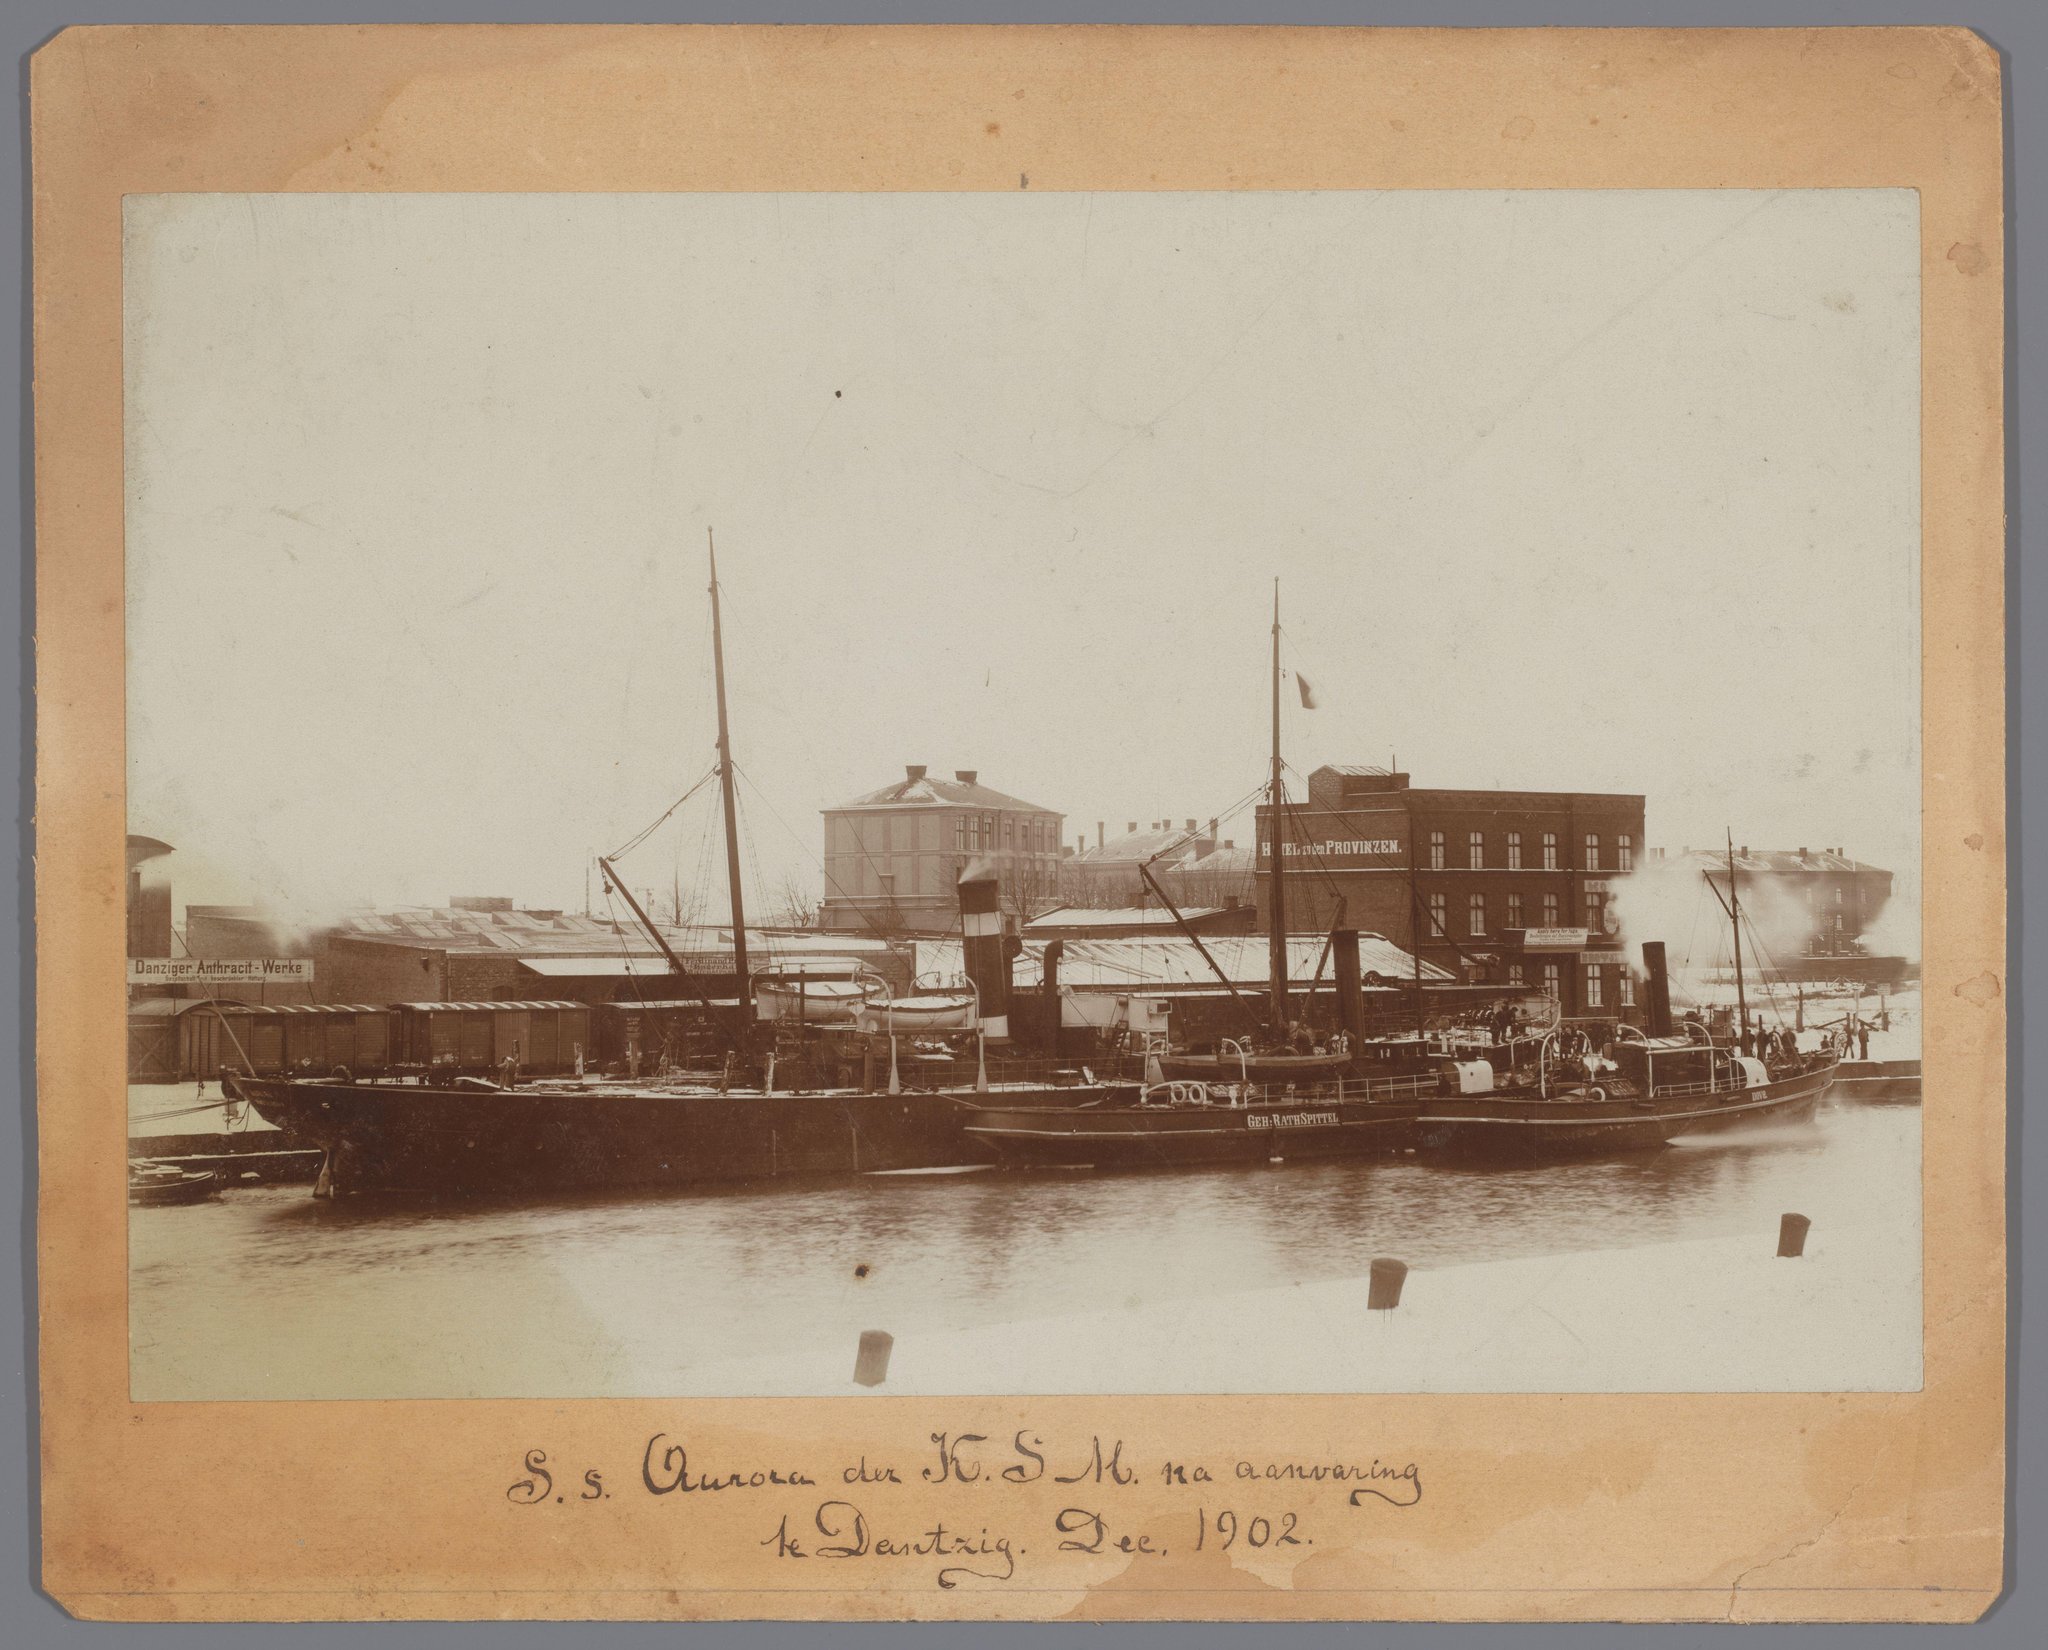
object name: photograph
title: S.S. Aurora der K.S.M. na aanvaring in de haven van Danzig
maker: a. schröder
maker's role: fotograaf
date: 1902-1912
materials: paper, cardboard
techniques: collodion silver print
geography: danzig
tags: harbour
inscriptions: inscription: ‘S.s. Aurora der K.S.M. na aanvaring/ te Dantzig. Dec. 1902’, stamp: ‘A. Schröder, Photogr.-Anstalt/ Neufahrwasser, Sasperstr.’